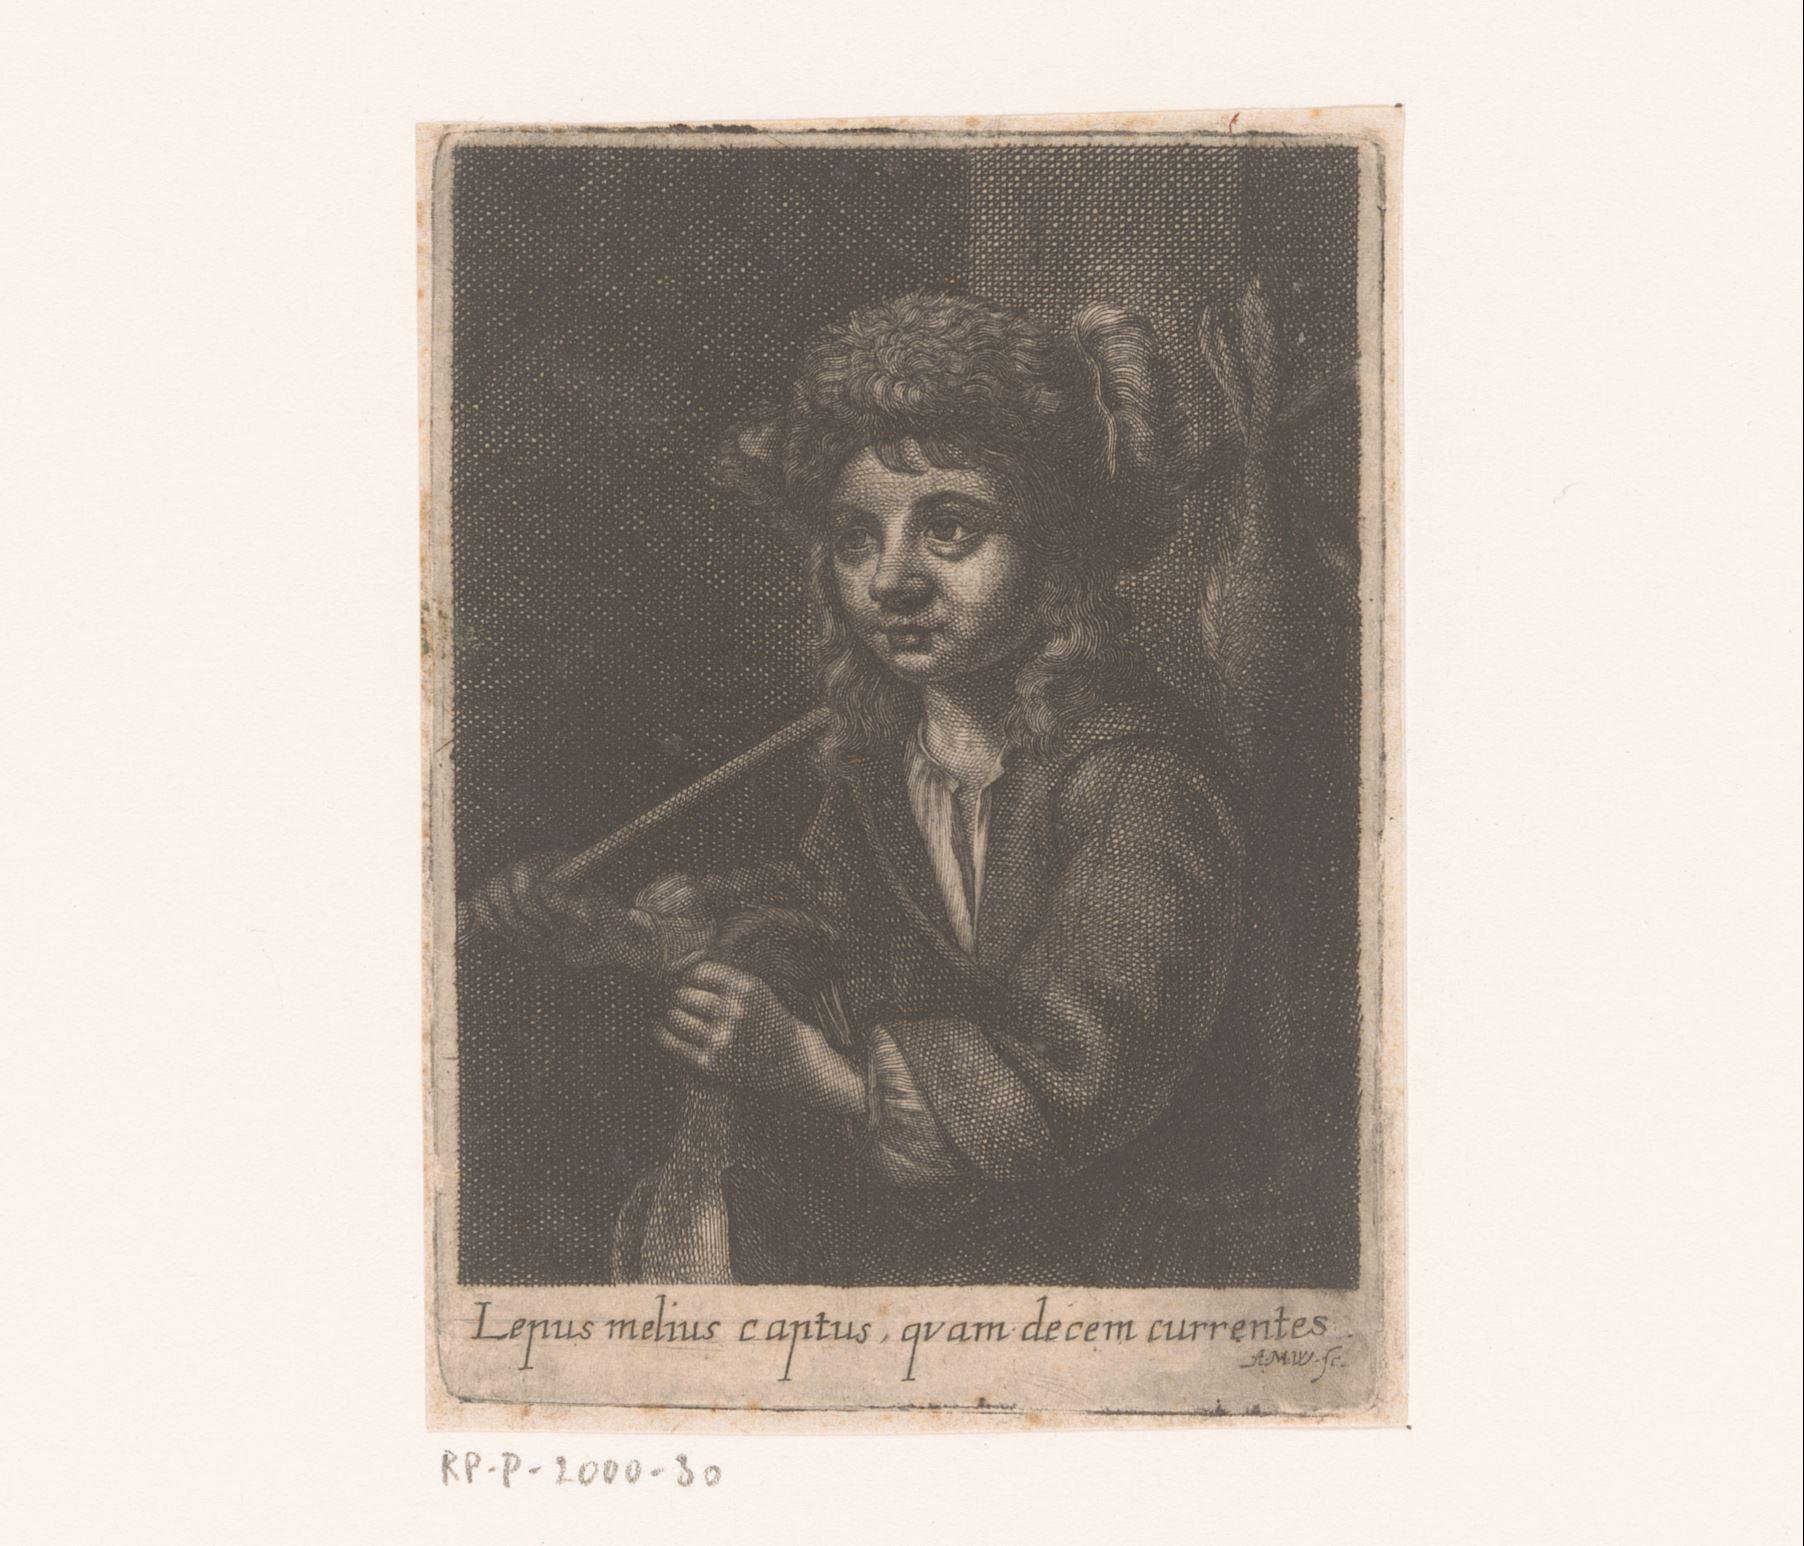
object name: print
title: Jonge jager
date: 1670-1736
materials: paper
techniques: engraving, intaglio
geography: germany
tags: carrying something with carrying-pole, boy (child between toddler and youth), hare-hunting, rabbit-hunting, bird hunting, head-gear: hat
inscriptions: collector's mark: Lugt 2228, collector's mark: Lugt 2760